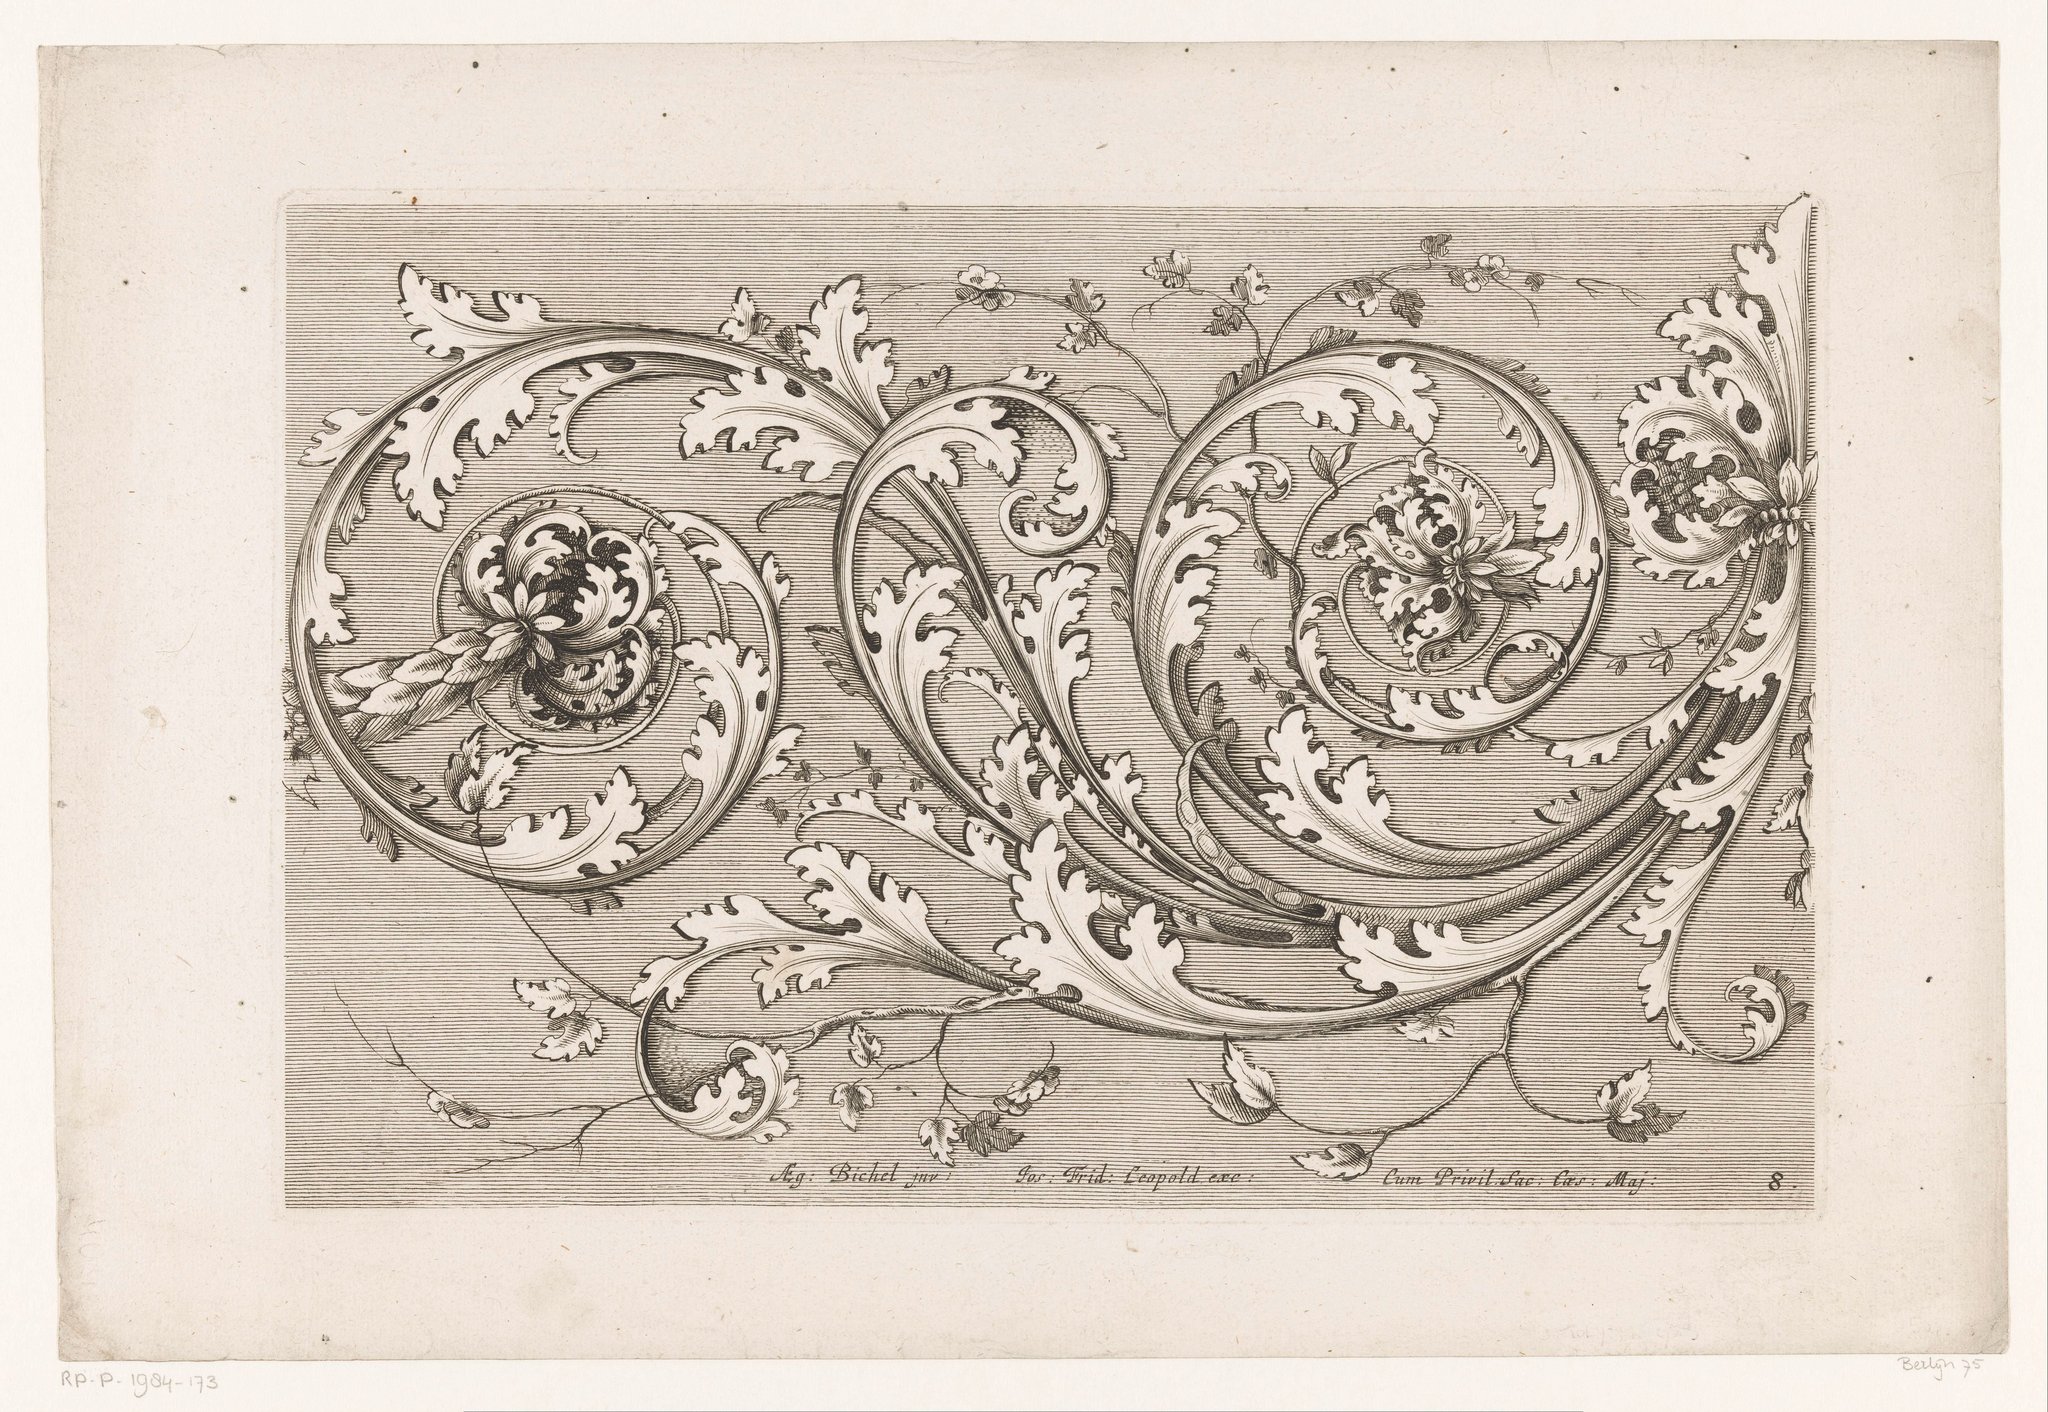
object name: ornament print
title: Allerhand Inventiones von Frantzösischem Laub-Werkh (...)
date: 1697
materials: paper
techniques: engraving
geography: augsburg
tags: acanthus ~ ornament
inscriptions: collector's mark: Lugt 2760, collector's mark: Lugt 2228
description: Acanthusranken met links de helft van een guirlande.